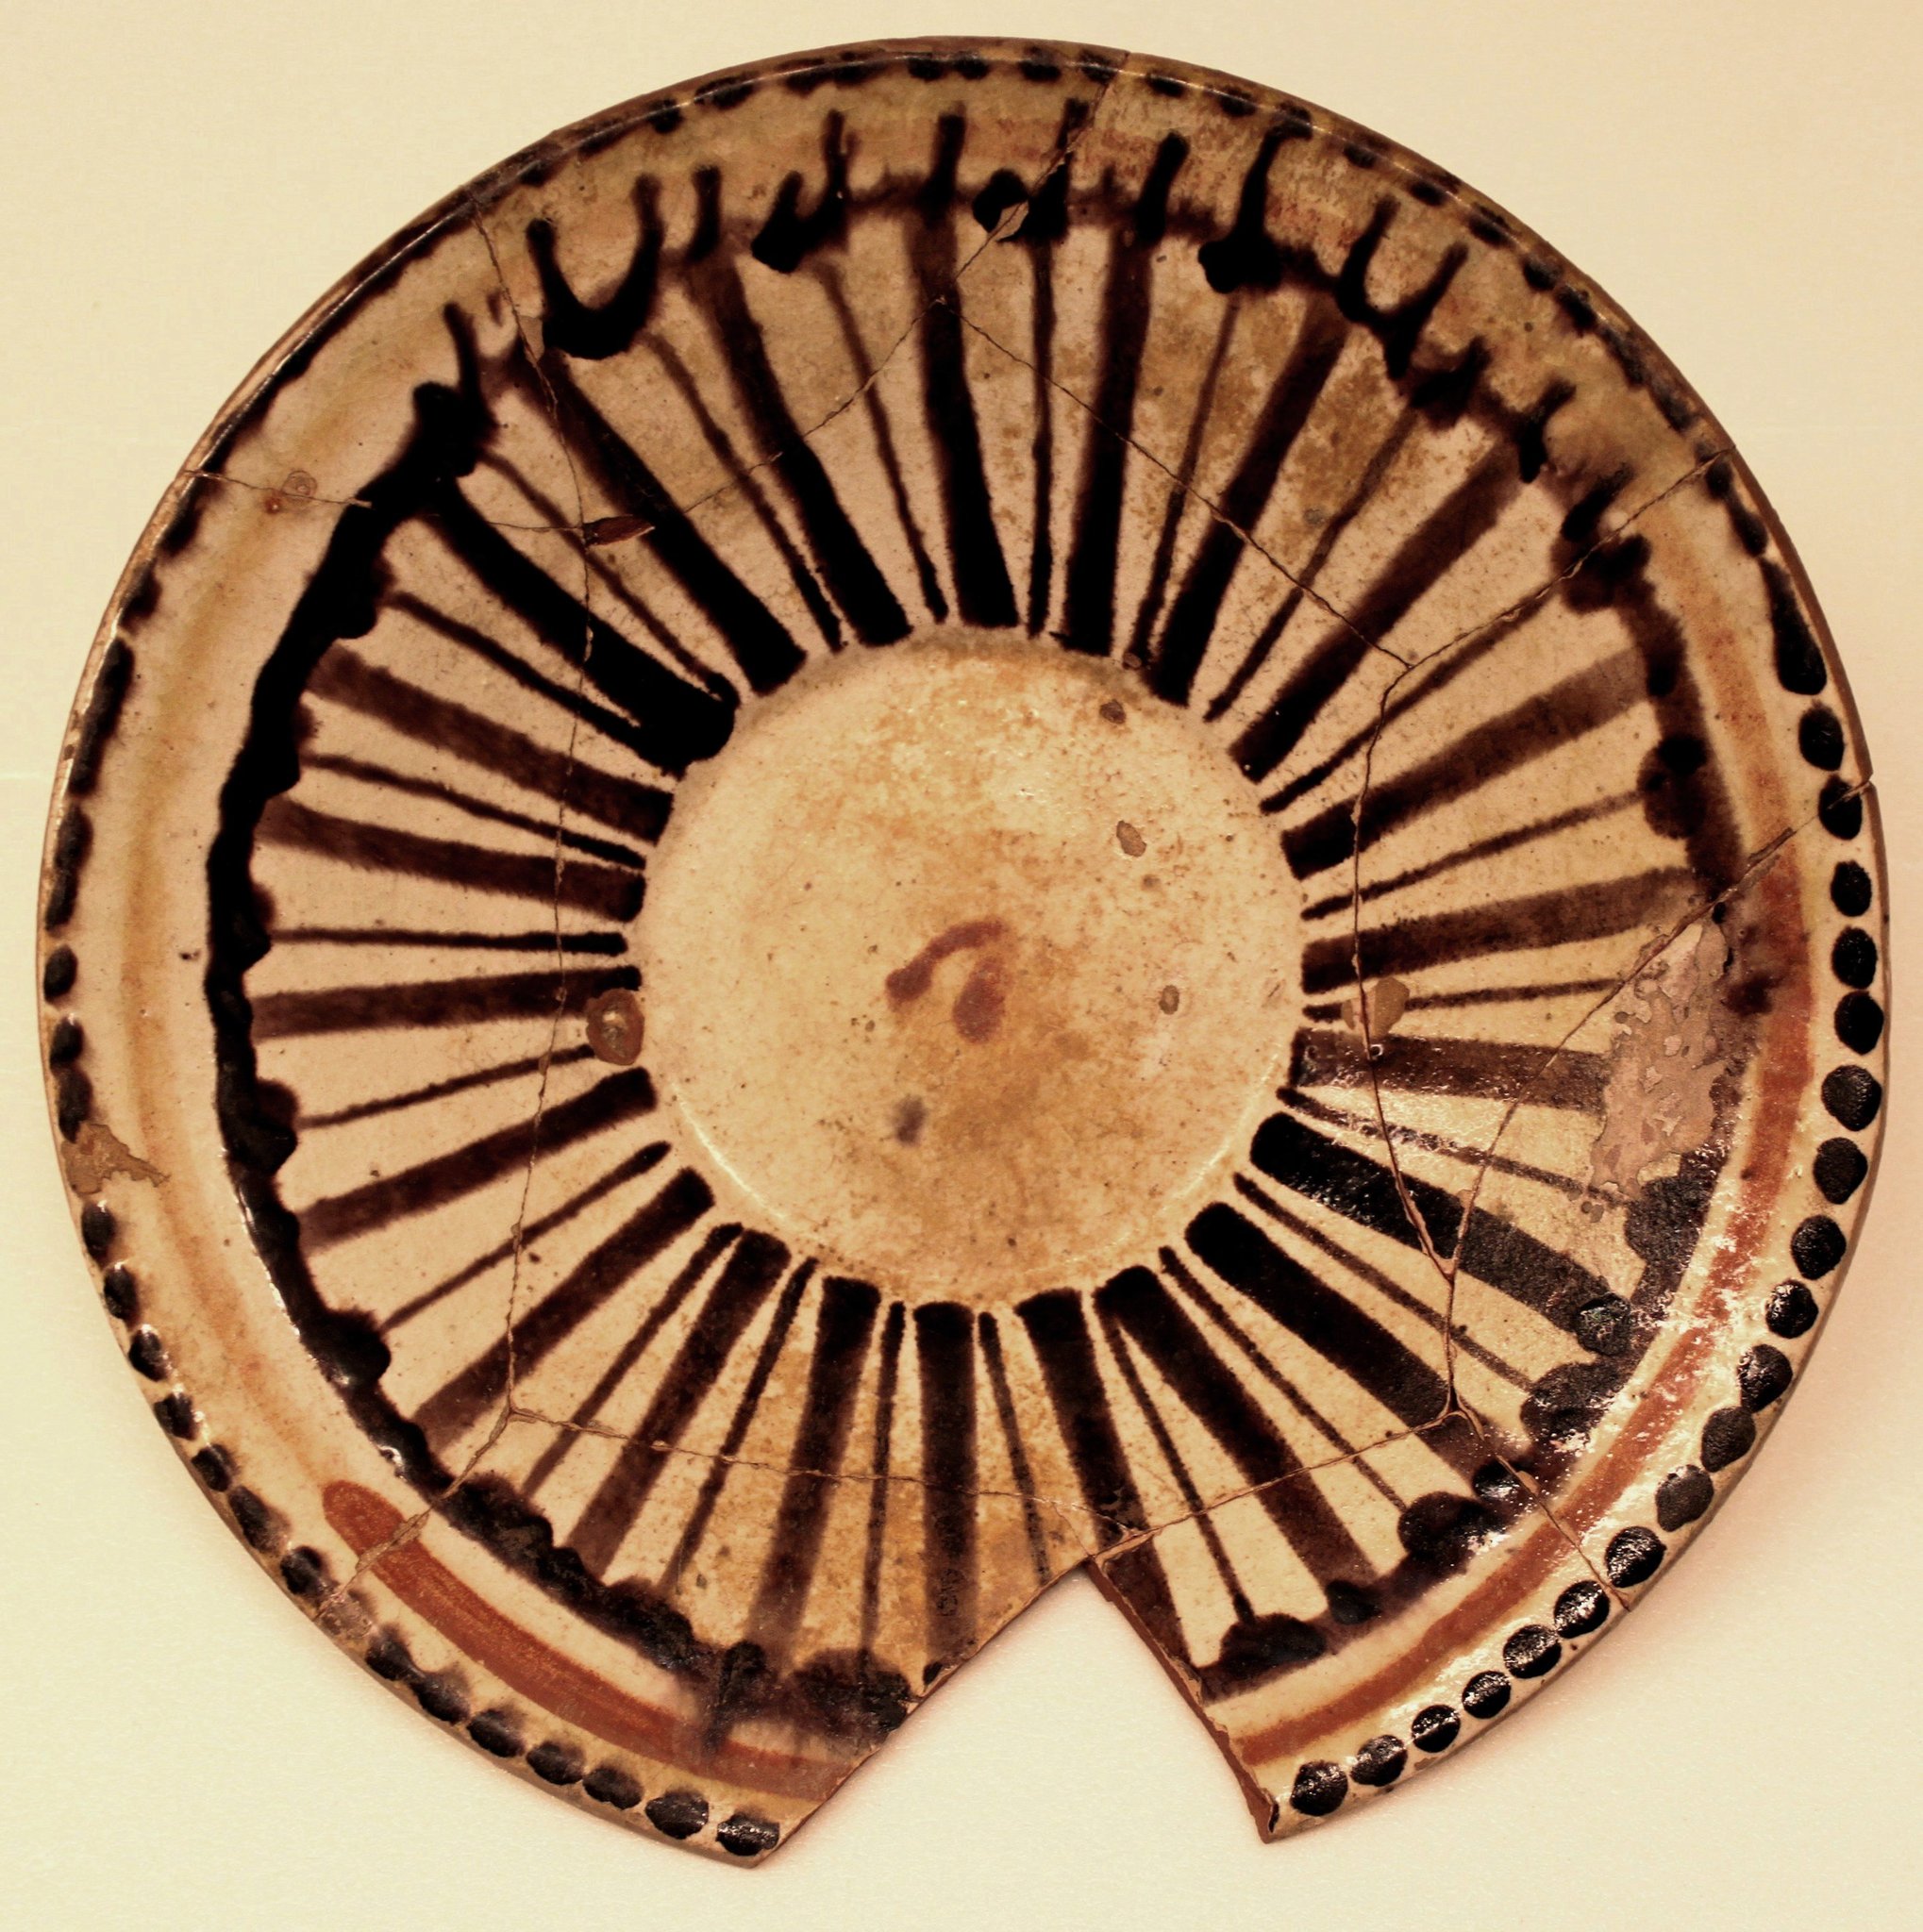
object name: dish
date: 801-900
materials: earthenware, glaze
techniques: polychrome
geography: iran